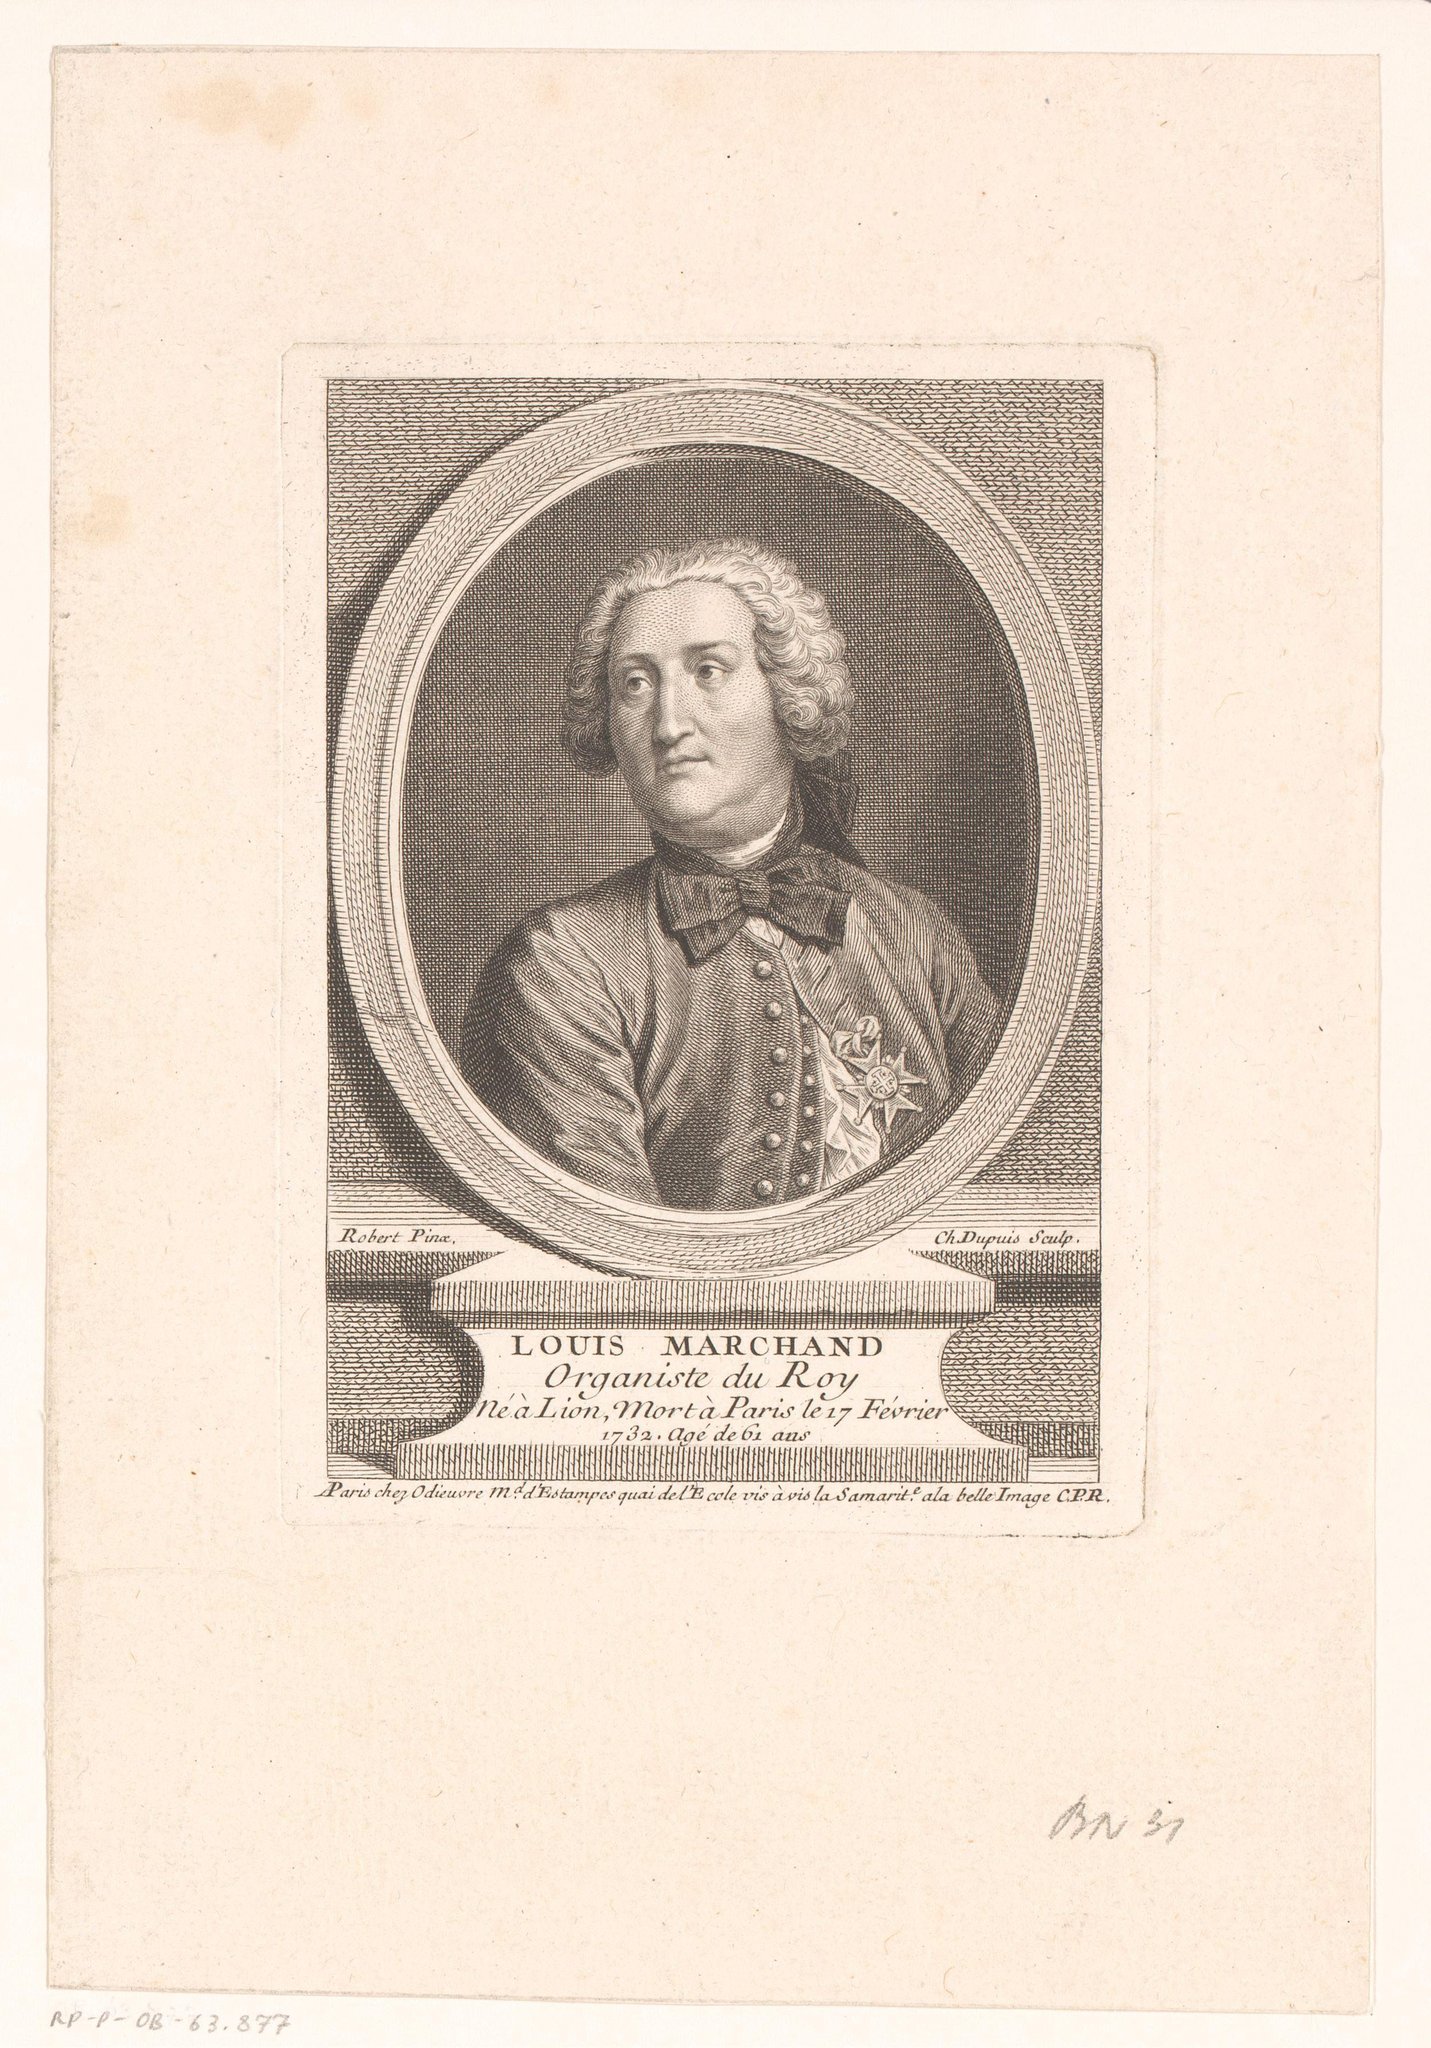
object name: book illustration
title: Portret van Louis Marchand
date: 1738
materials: paper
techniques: engraving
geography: paris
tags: lyon, ornament ~ medallion, portrait of composer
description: Mogelijk prent uit: Dreux du Radier, Jean-François. L'Europe illustré, contenant l'histoire abregée des souverains, des princes, des prélats, des ministres, (...) en Europe: dans le XVe. siècle compris, jusqu'à présent. Parijs: Michel Odieuvre en Jean-Luc Nyon, 1755, dl. 5.